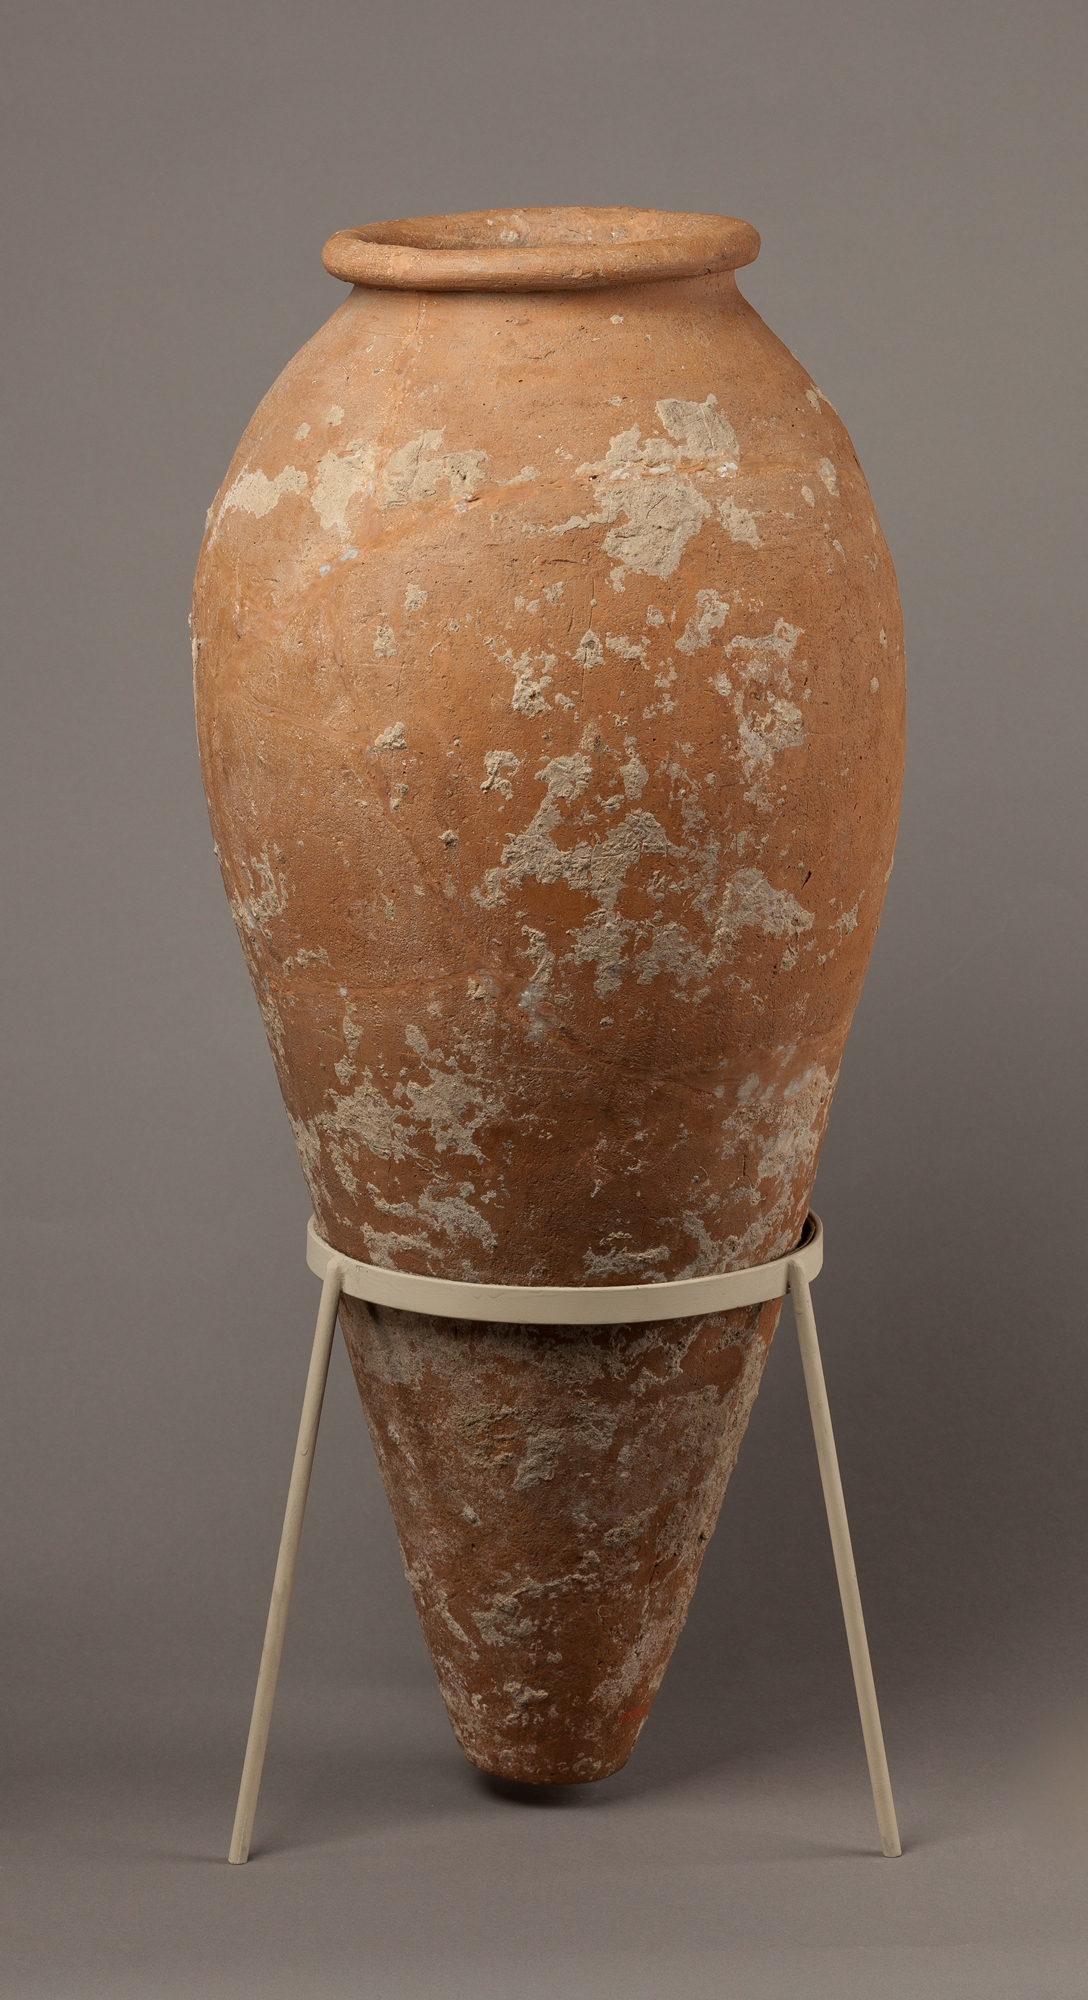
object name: jar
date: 3100-2649 BCE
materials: pottery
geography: egypt